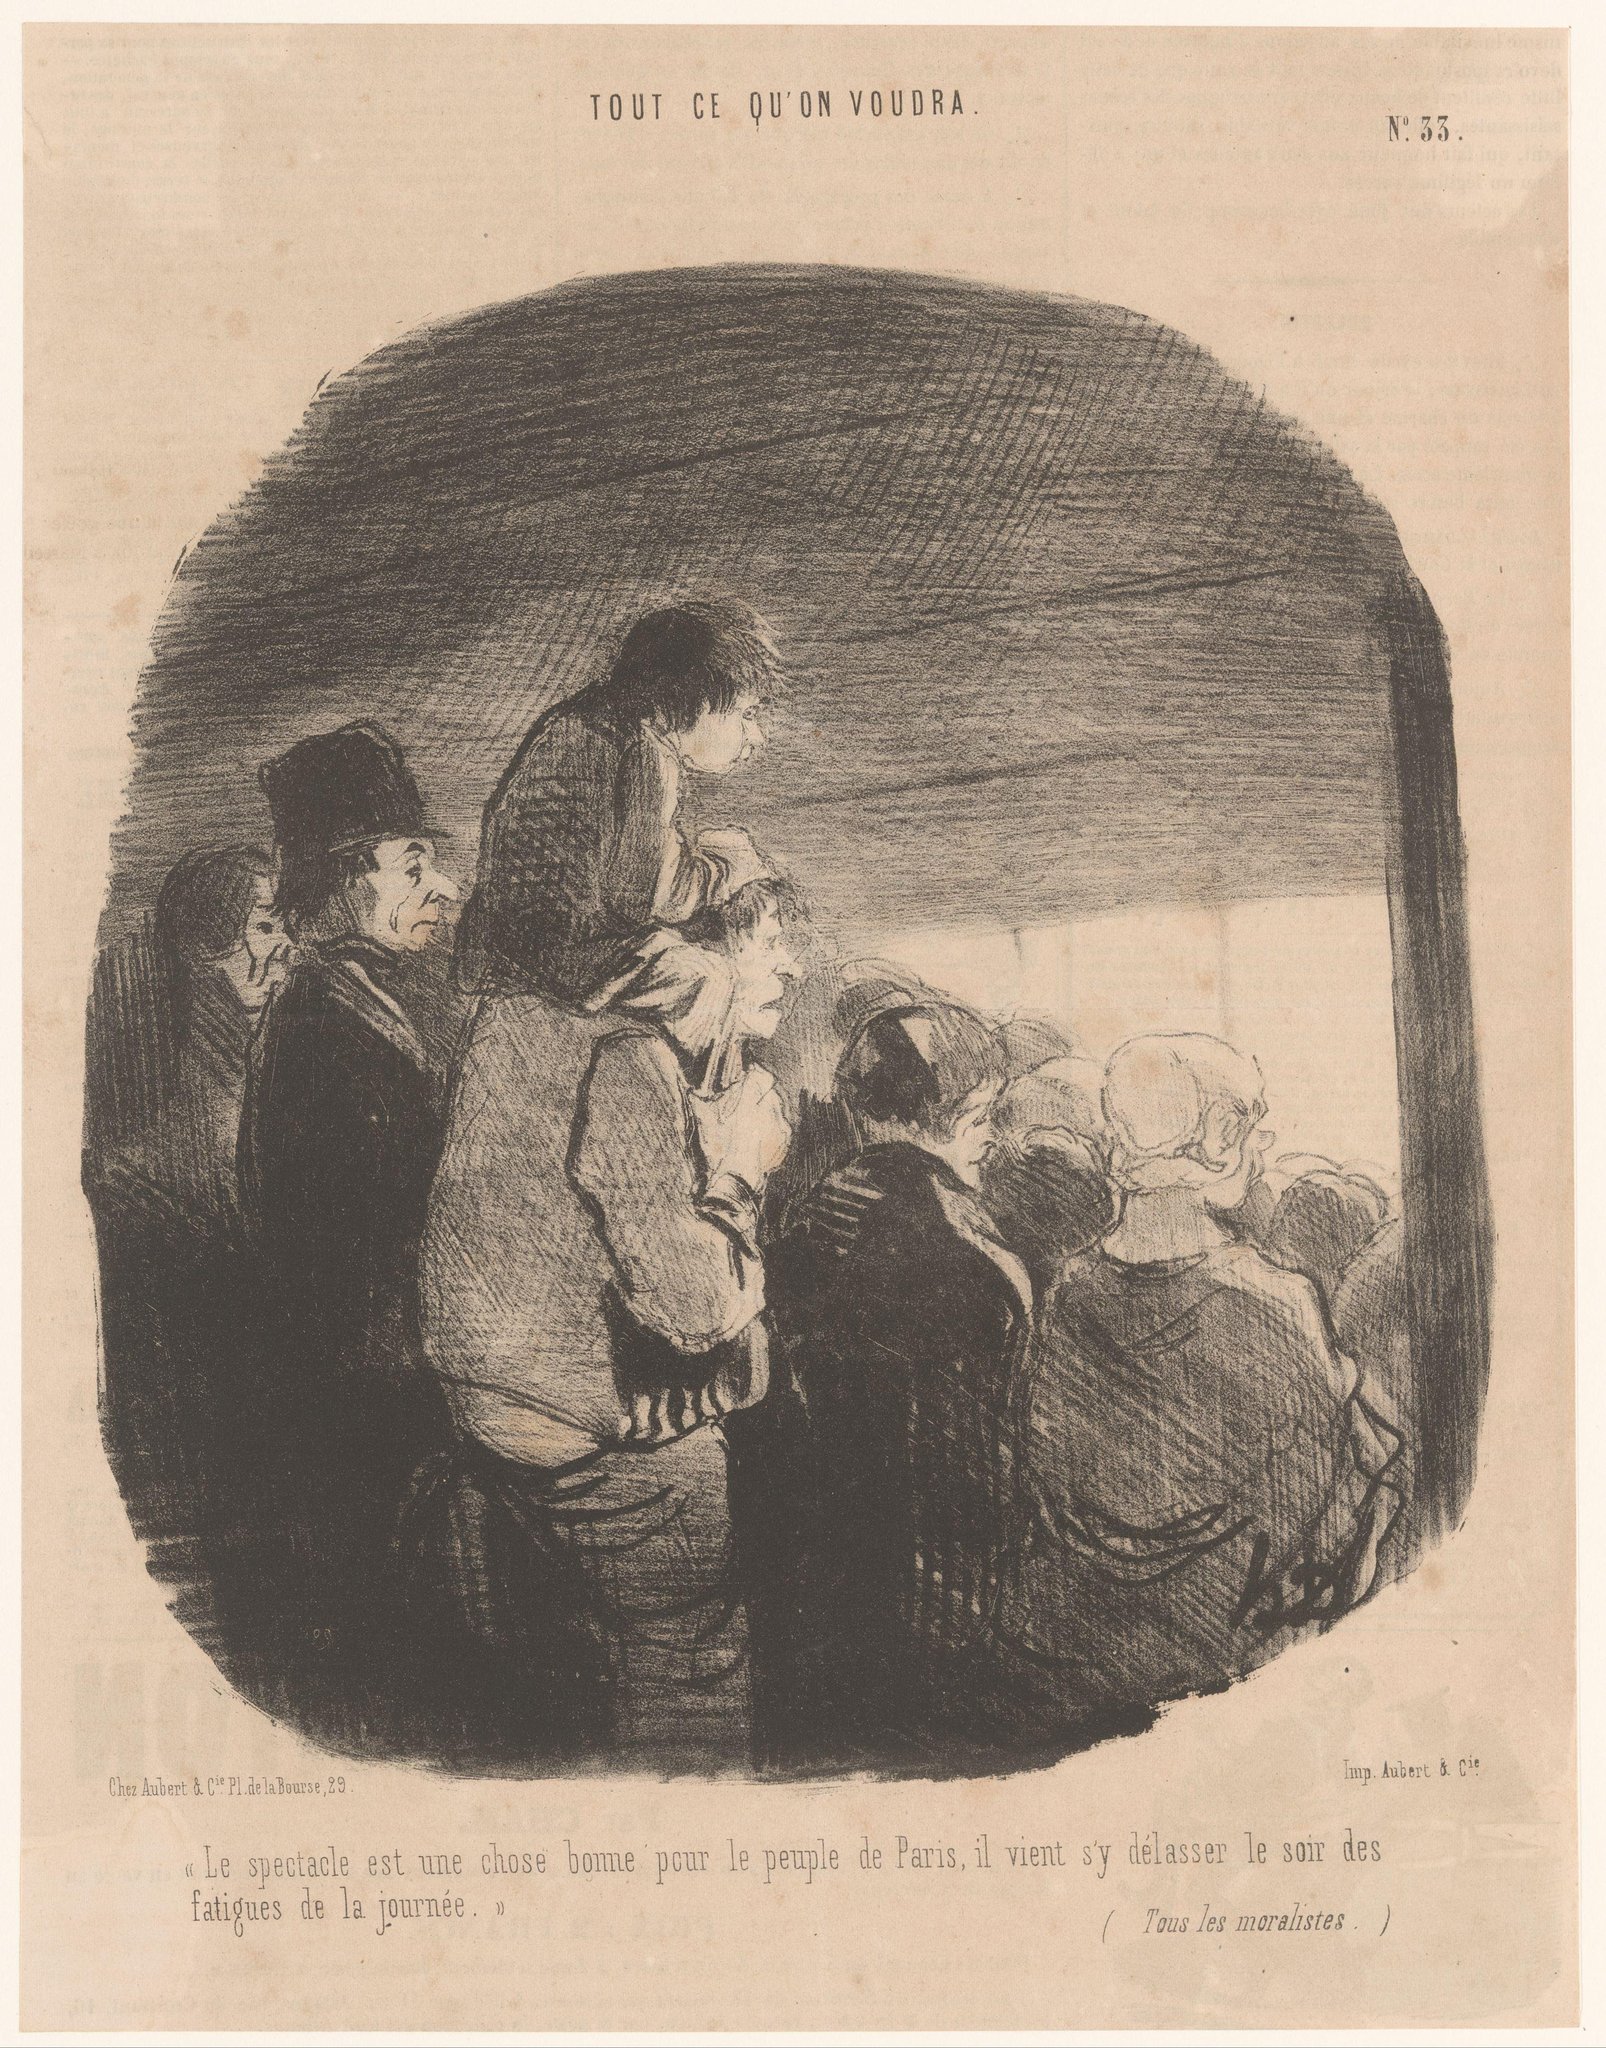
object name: cartoon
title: Tout ce qu'on voudra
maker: honoré daumier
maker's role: draughtsman, painter, print maker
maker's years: 1808-1879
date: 1849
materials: paper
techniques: lithograph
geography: paris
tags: theatre, theatrical performance, caricatures (human types), paris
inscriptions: collector's mark: Lugt 2228a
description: Prent gebruikt voor: Le Charivari, 14 februari 1849.